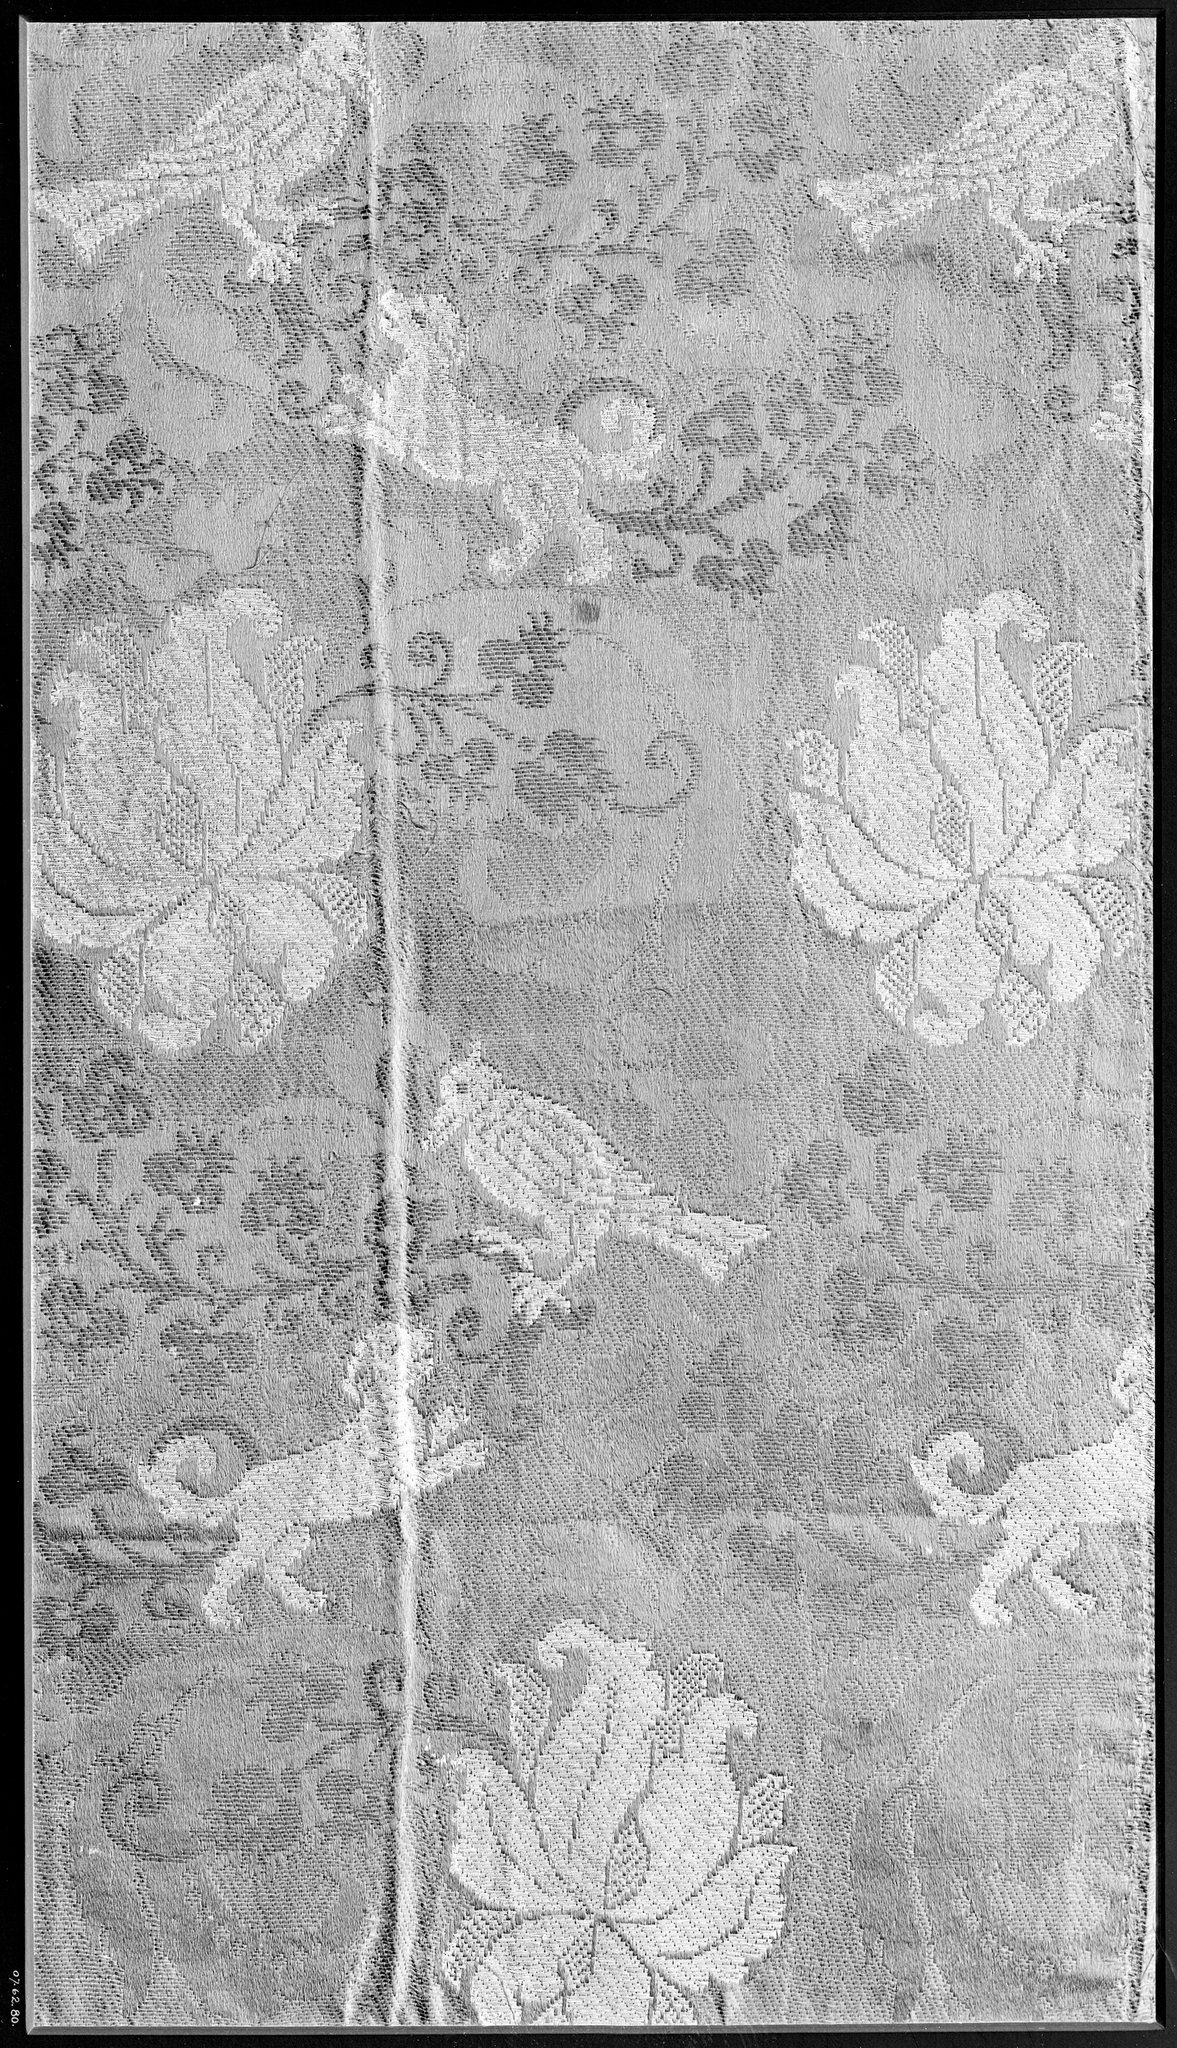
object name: piece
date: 1701-1800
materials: metal thread, silk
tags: birds,dogs,flowers